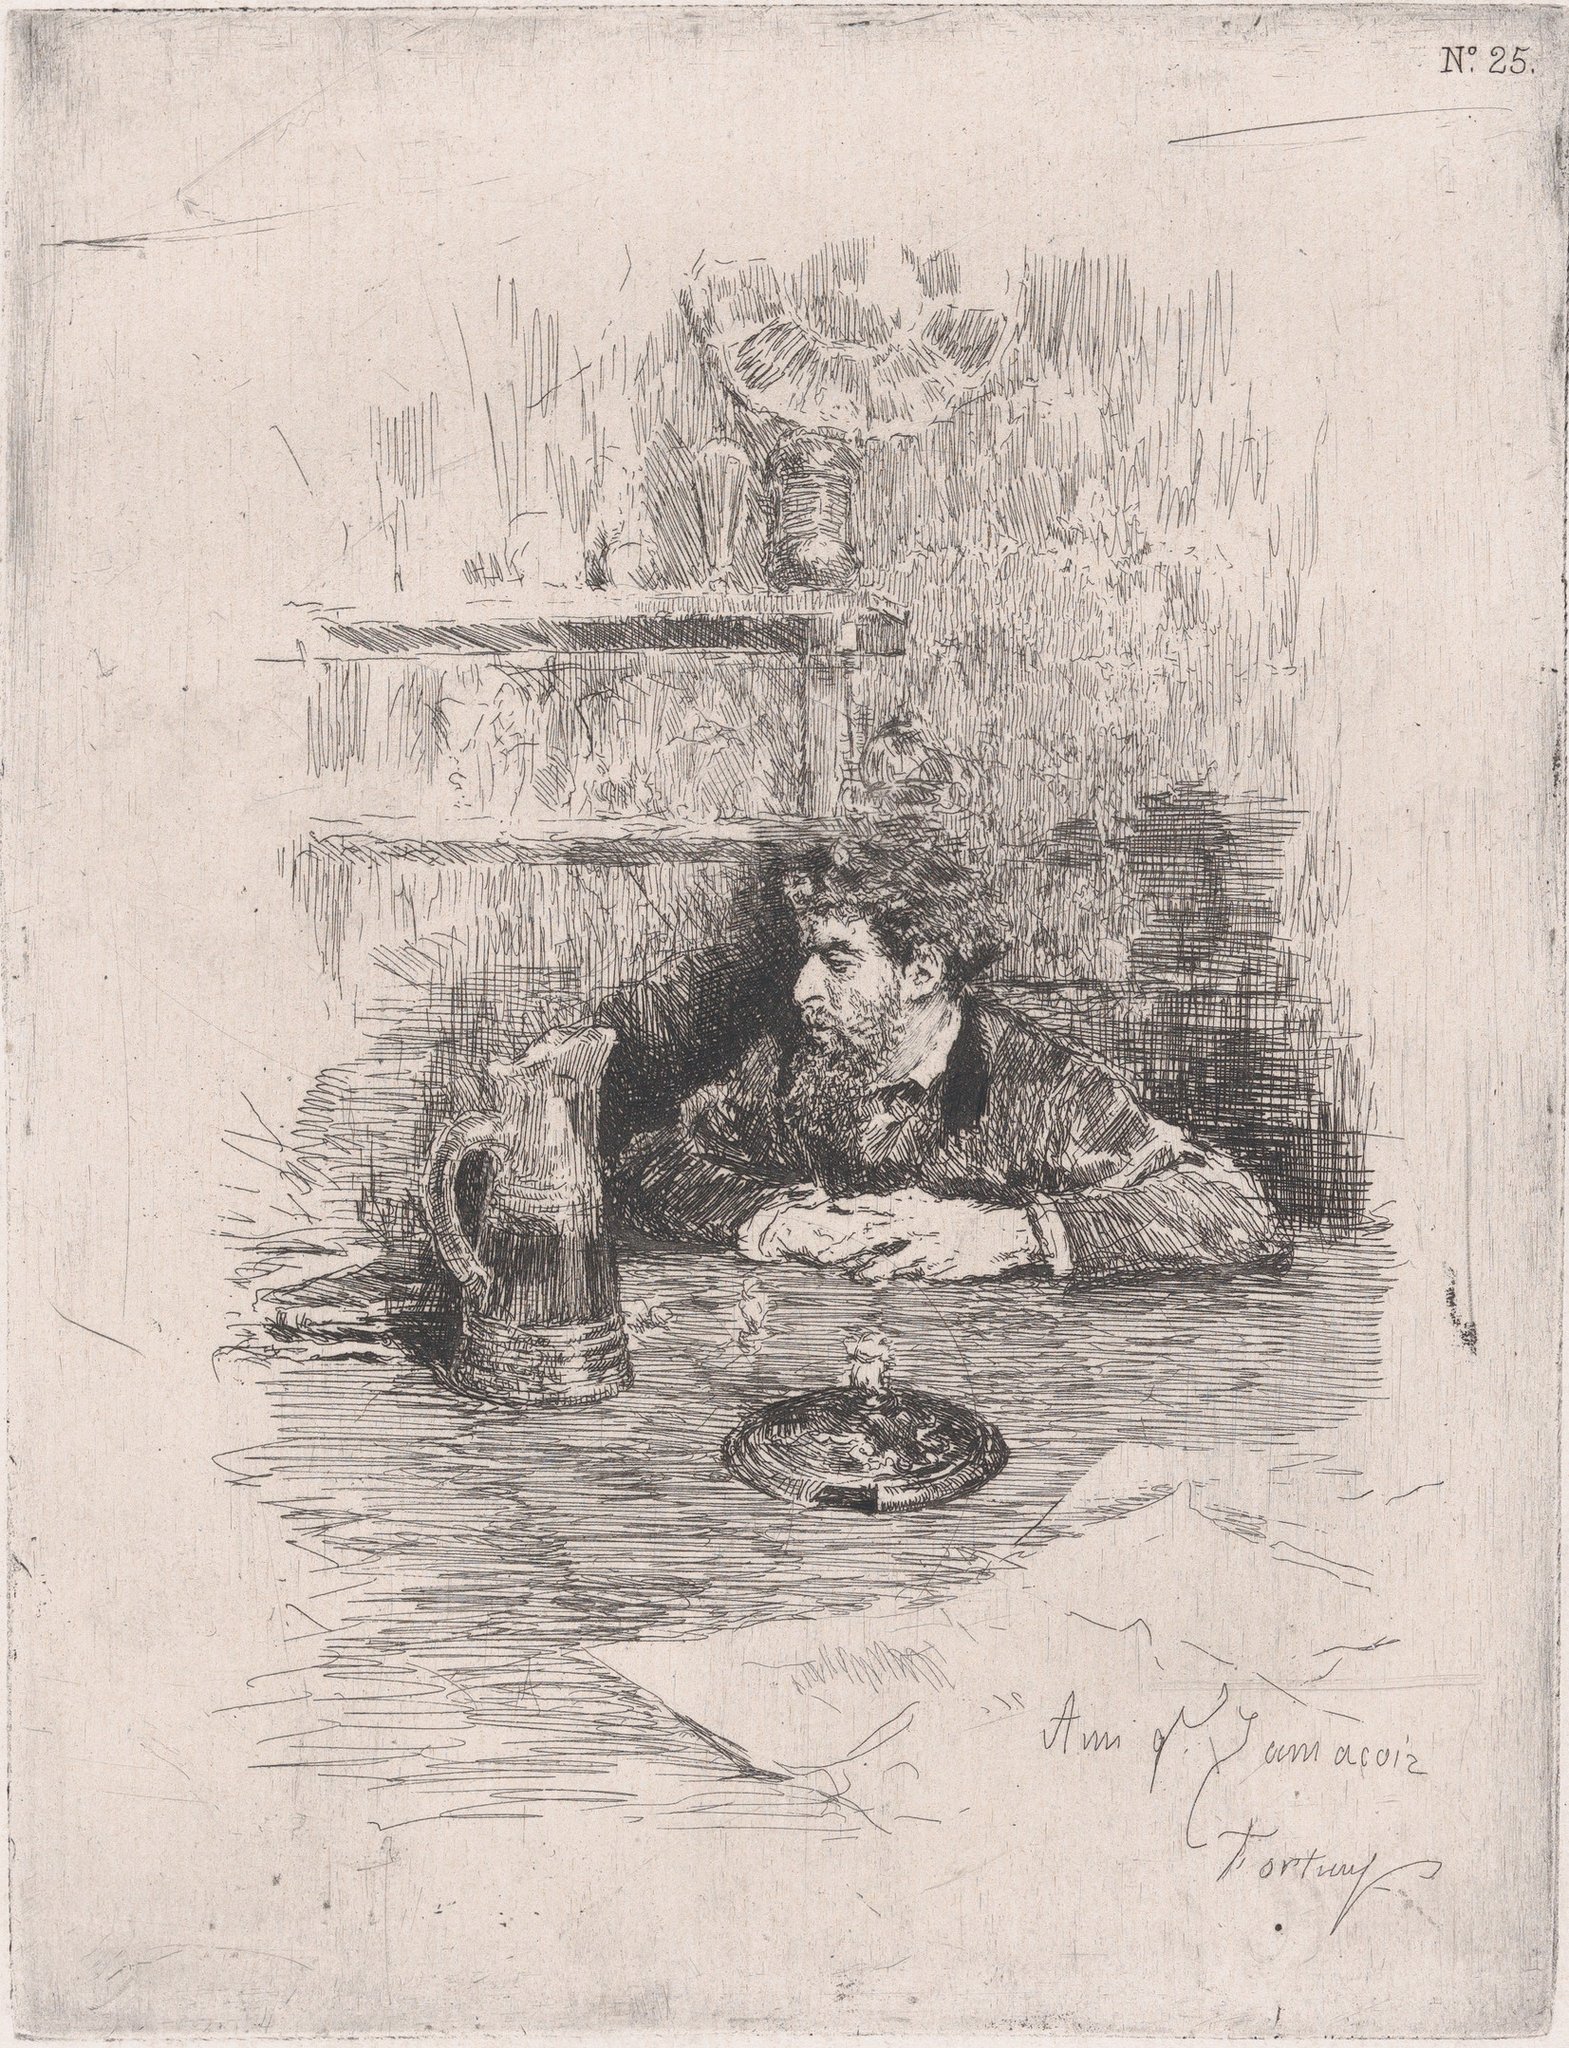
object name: print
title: Portrait of the painter Eduardo Zamacois seated at a table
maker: mariano fortuny, 1838–1874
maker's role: artist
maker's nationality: spanish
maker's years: 1838-1874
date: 1869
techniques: etching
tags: men,artists,pitchers